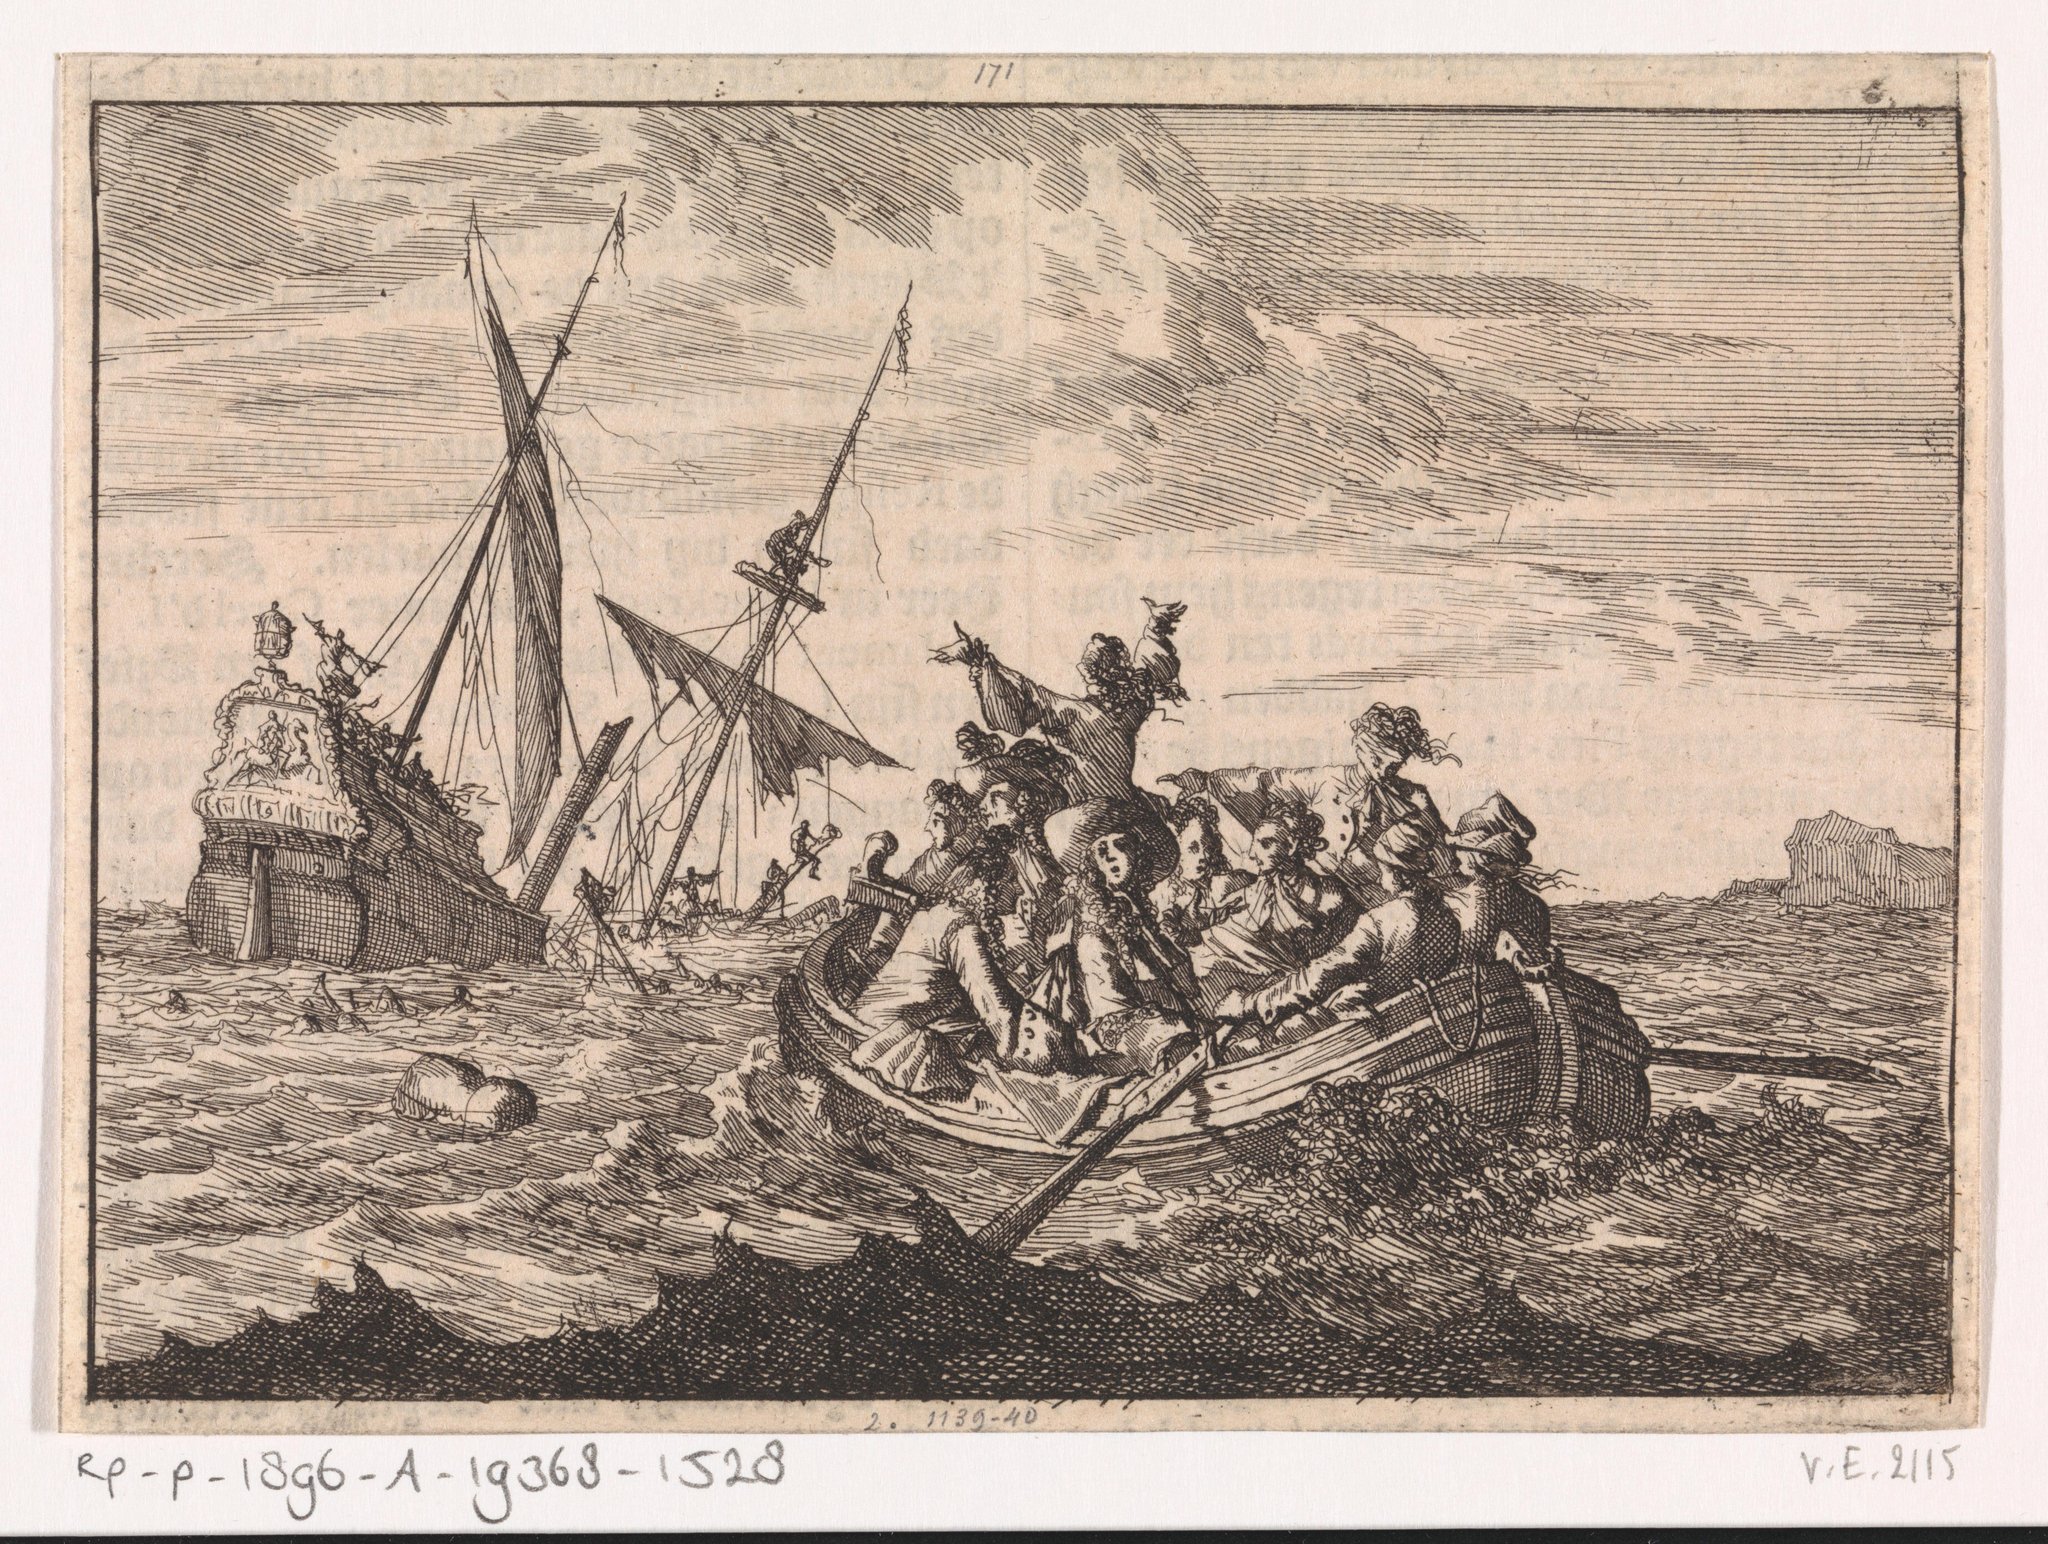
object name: print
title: Schipbreuk van de hertog van York onderweg naar Edinburg, 1683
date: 1698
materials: paper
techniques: etching, letterpress printing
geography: amsterdam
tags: james stuart (hertog van york), shipwreck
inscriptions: collector's mark: Lugt 2228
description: Illustratie uit: Gottfried, Johann Ludwig. Historische kronyck; vervattende een (...) beschrijvingh der aldergedenckwaerdigste geschiedenissen des weerelds, van den aenvangh der scheppingh tot (...) 1576 (2 delen). Leiden: Pieter van der Aa, 1698, dl. II, p. 1139.